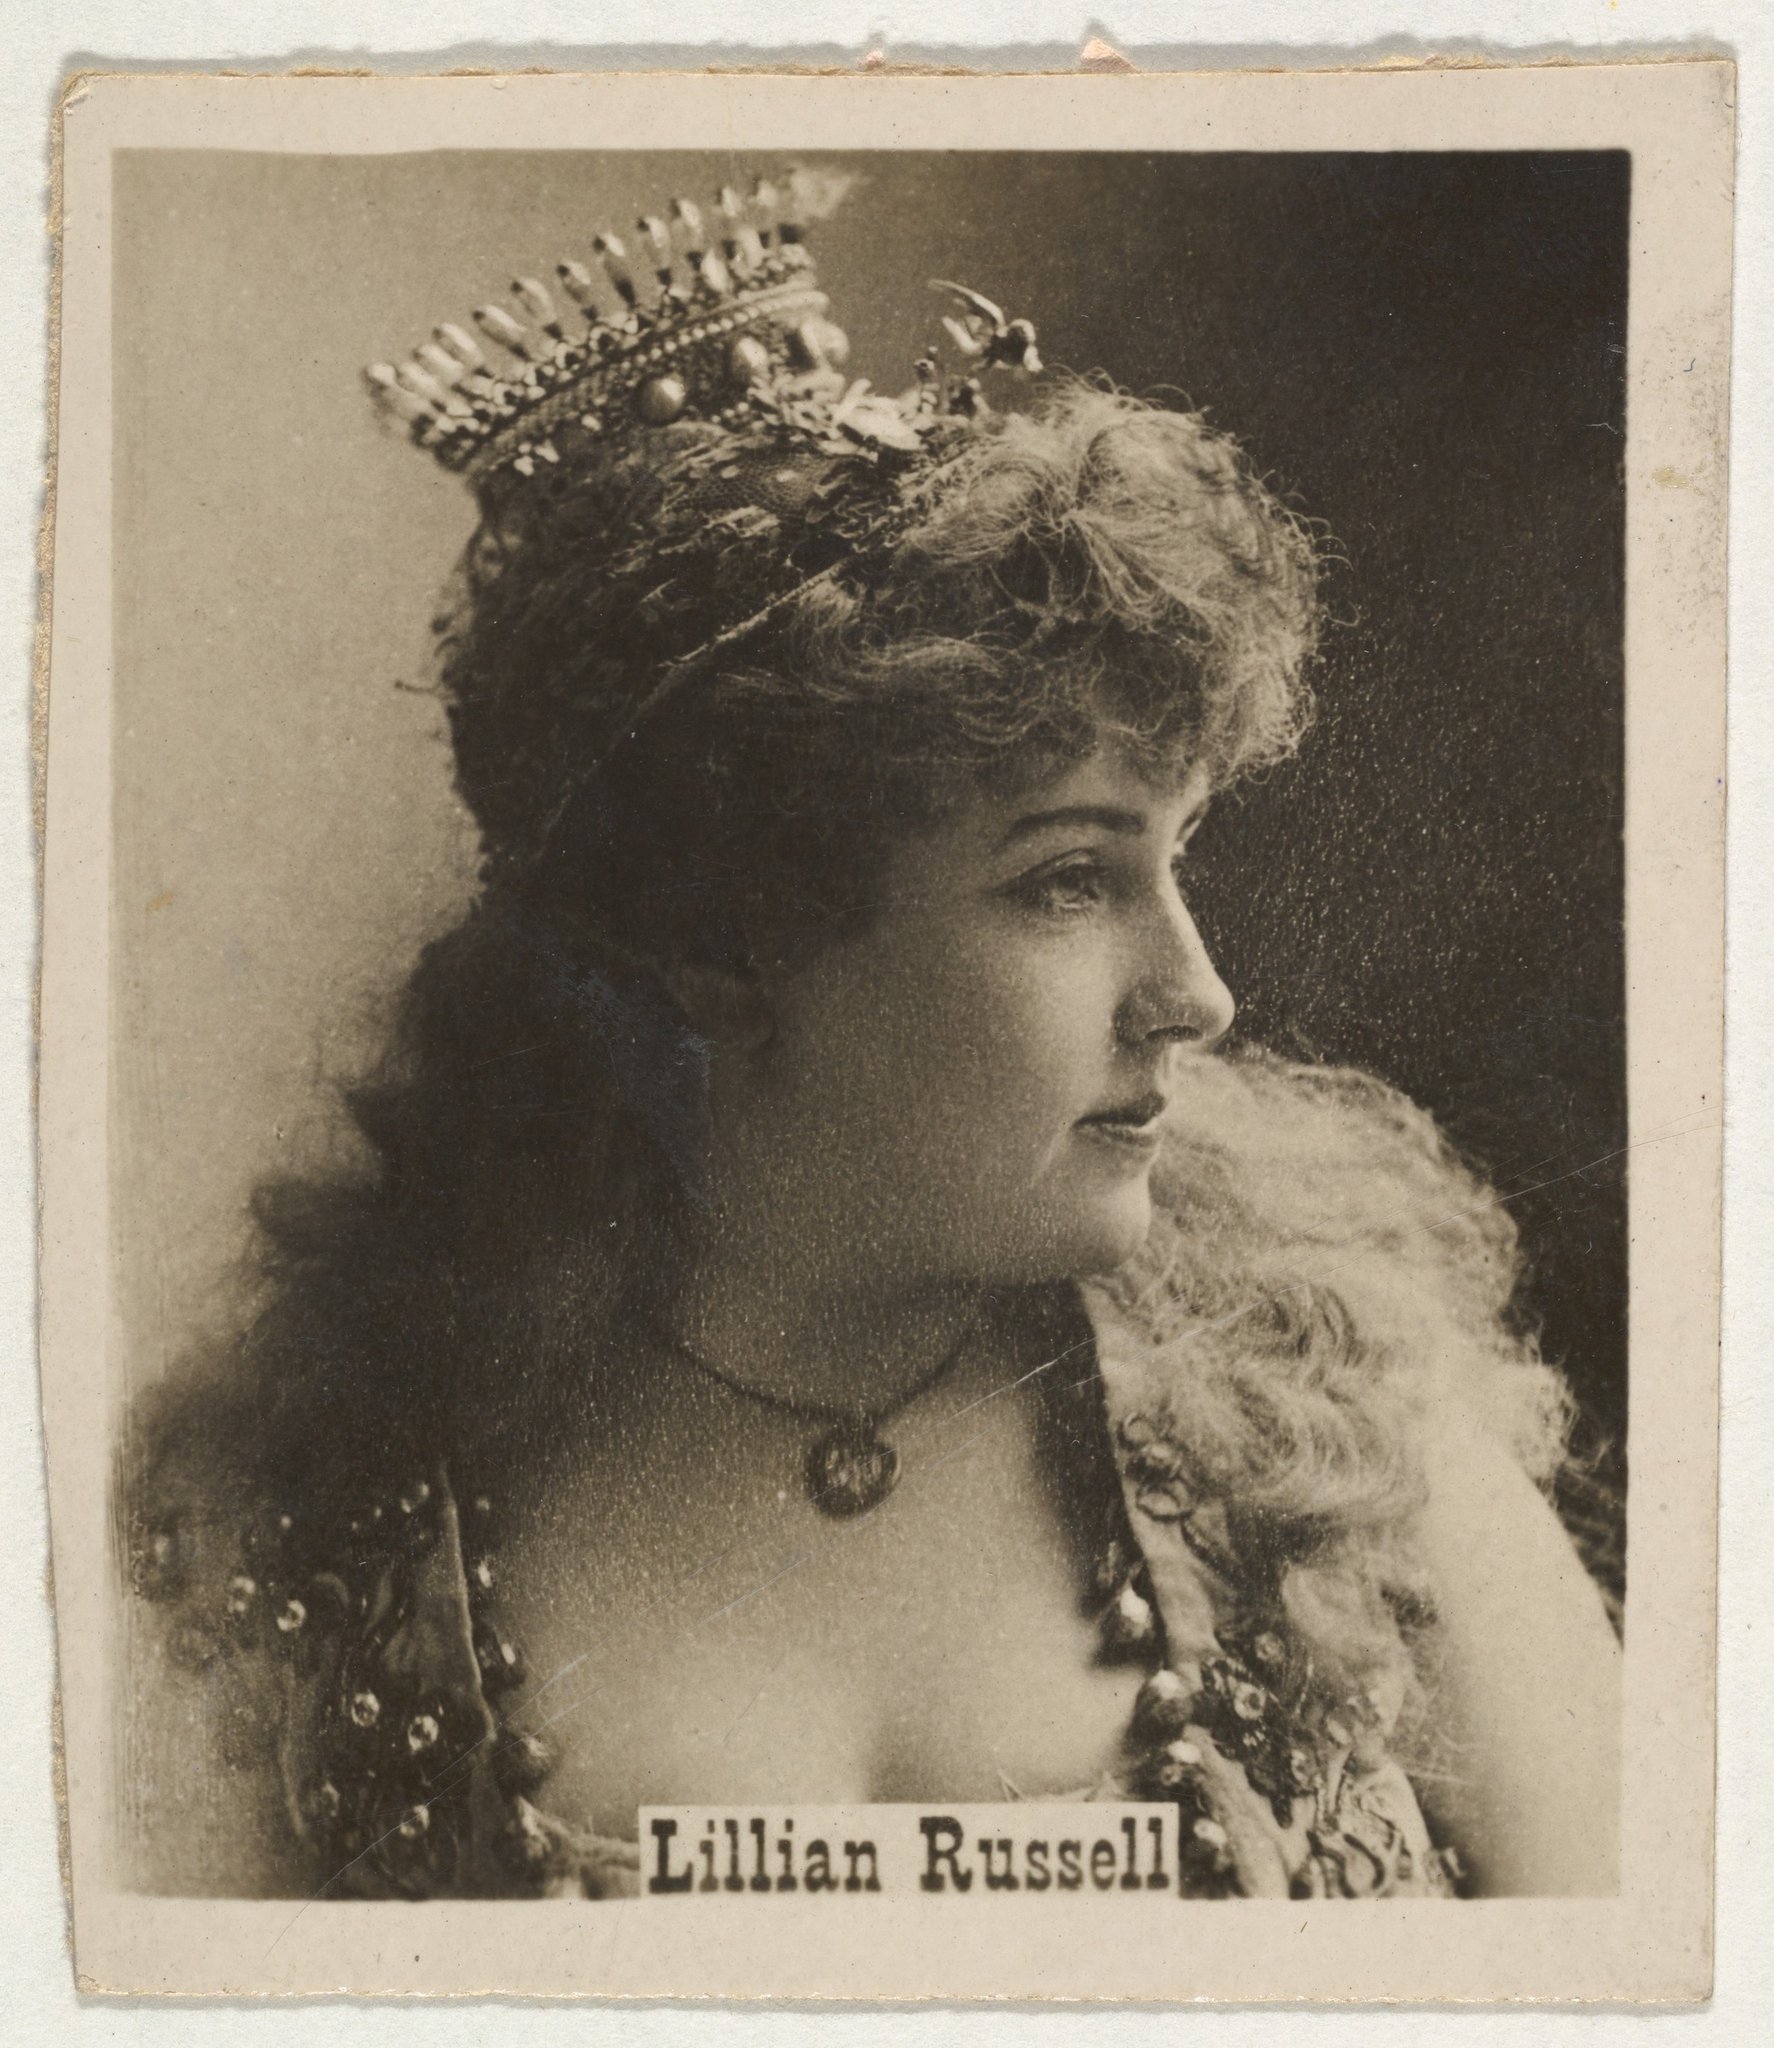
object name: print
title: Lillian Russell, from the Actresses series (T123, Type 1), issued by Neil McCoull Co.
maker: neil mccoull co.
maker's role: publisher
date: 1897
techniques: albumen print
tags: portraits,women,actresses